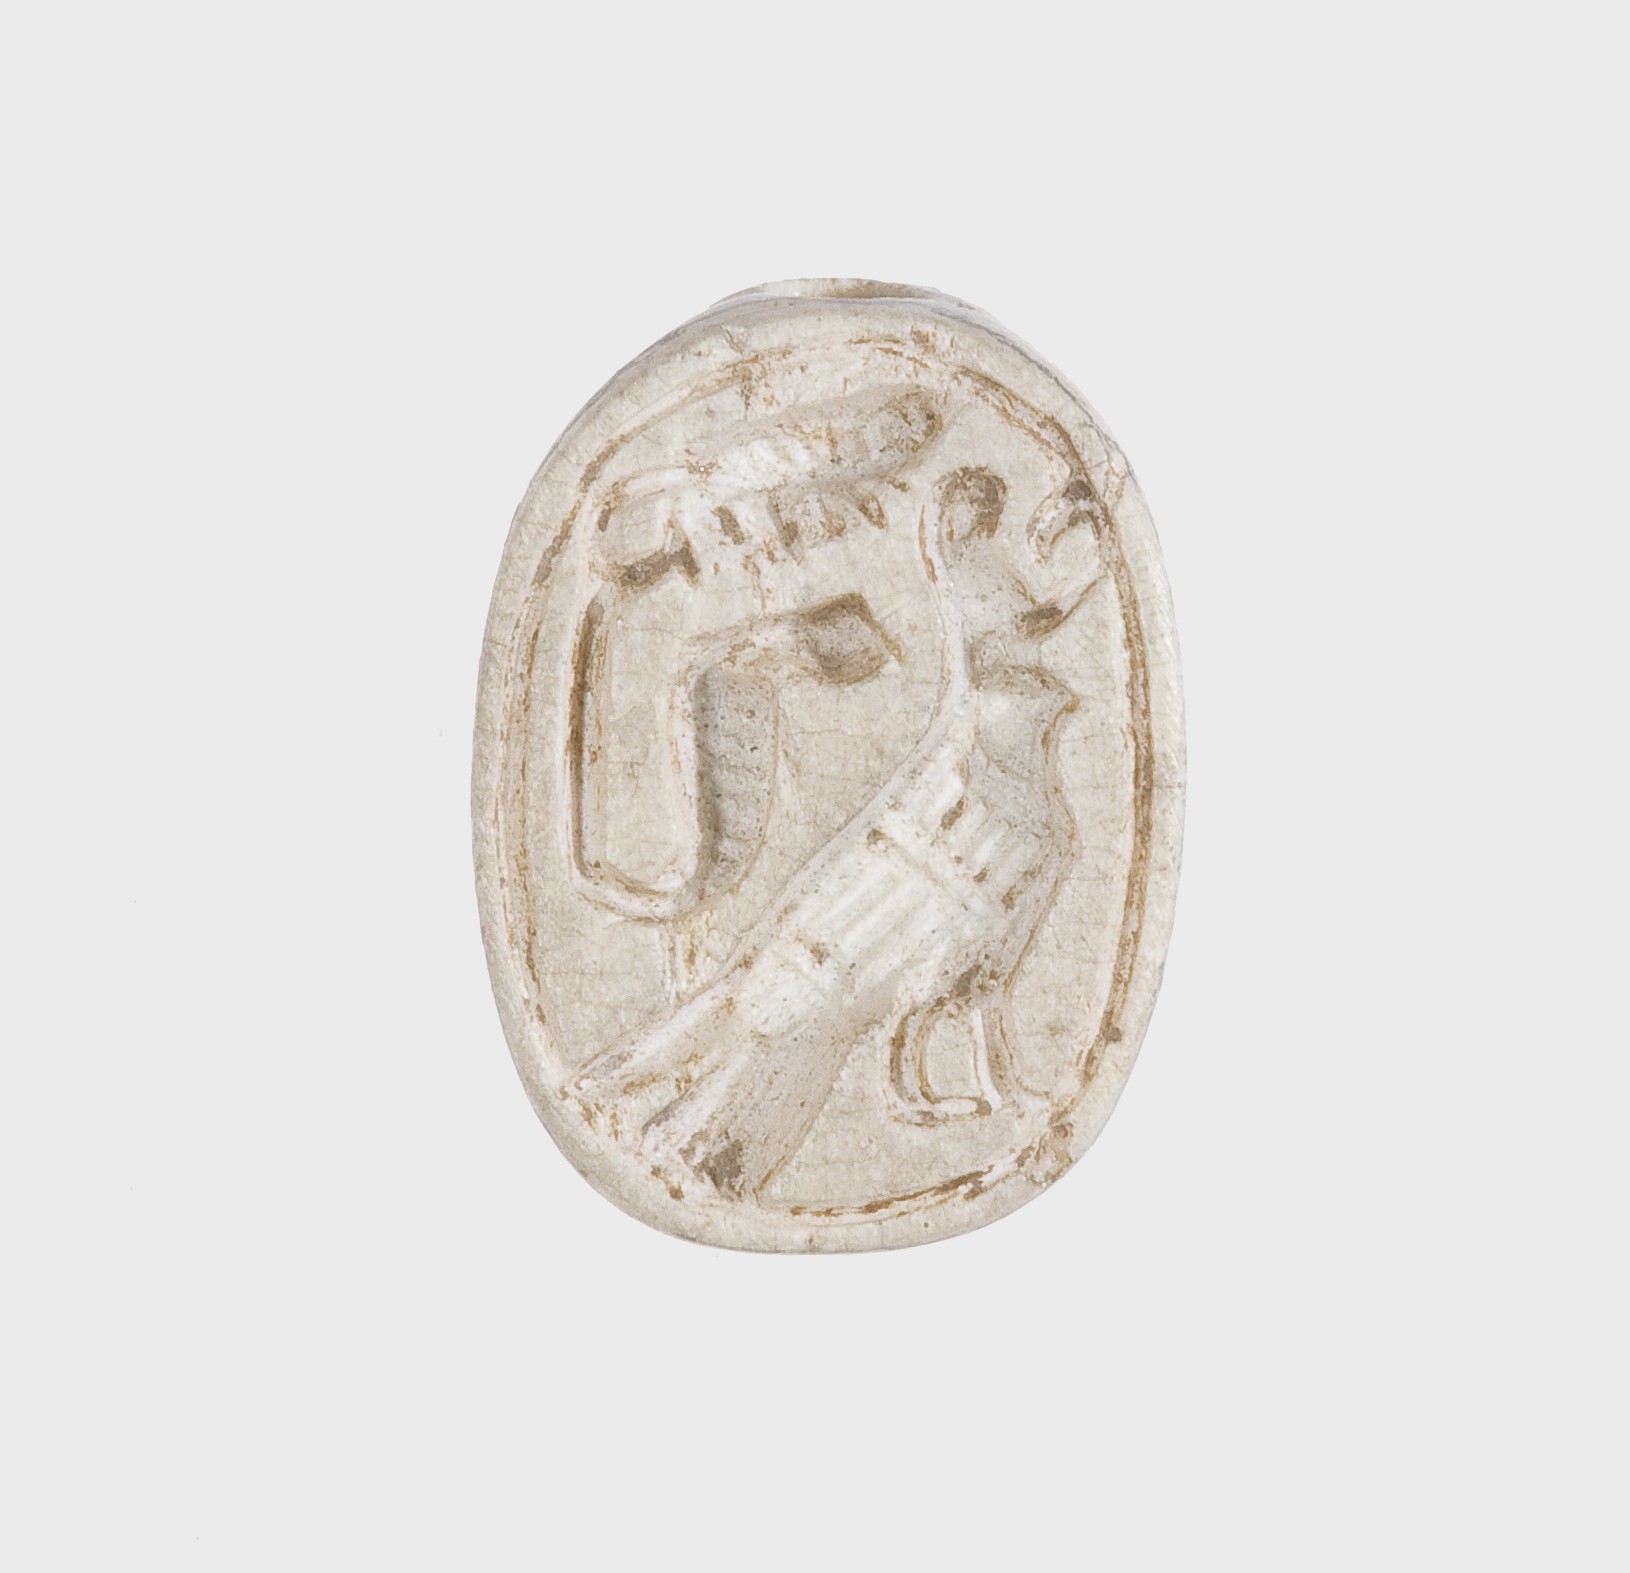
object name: scarab, horus falcon, uraeus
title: Scarab Inscribed with the Horus Falcon and Uraeus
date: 1390-1352 BCE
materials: mica, stone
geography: egypt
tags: horus,scarabs